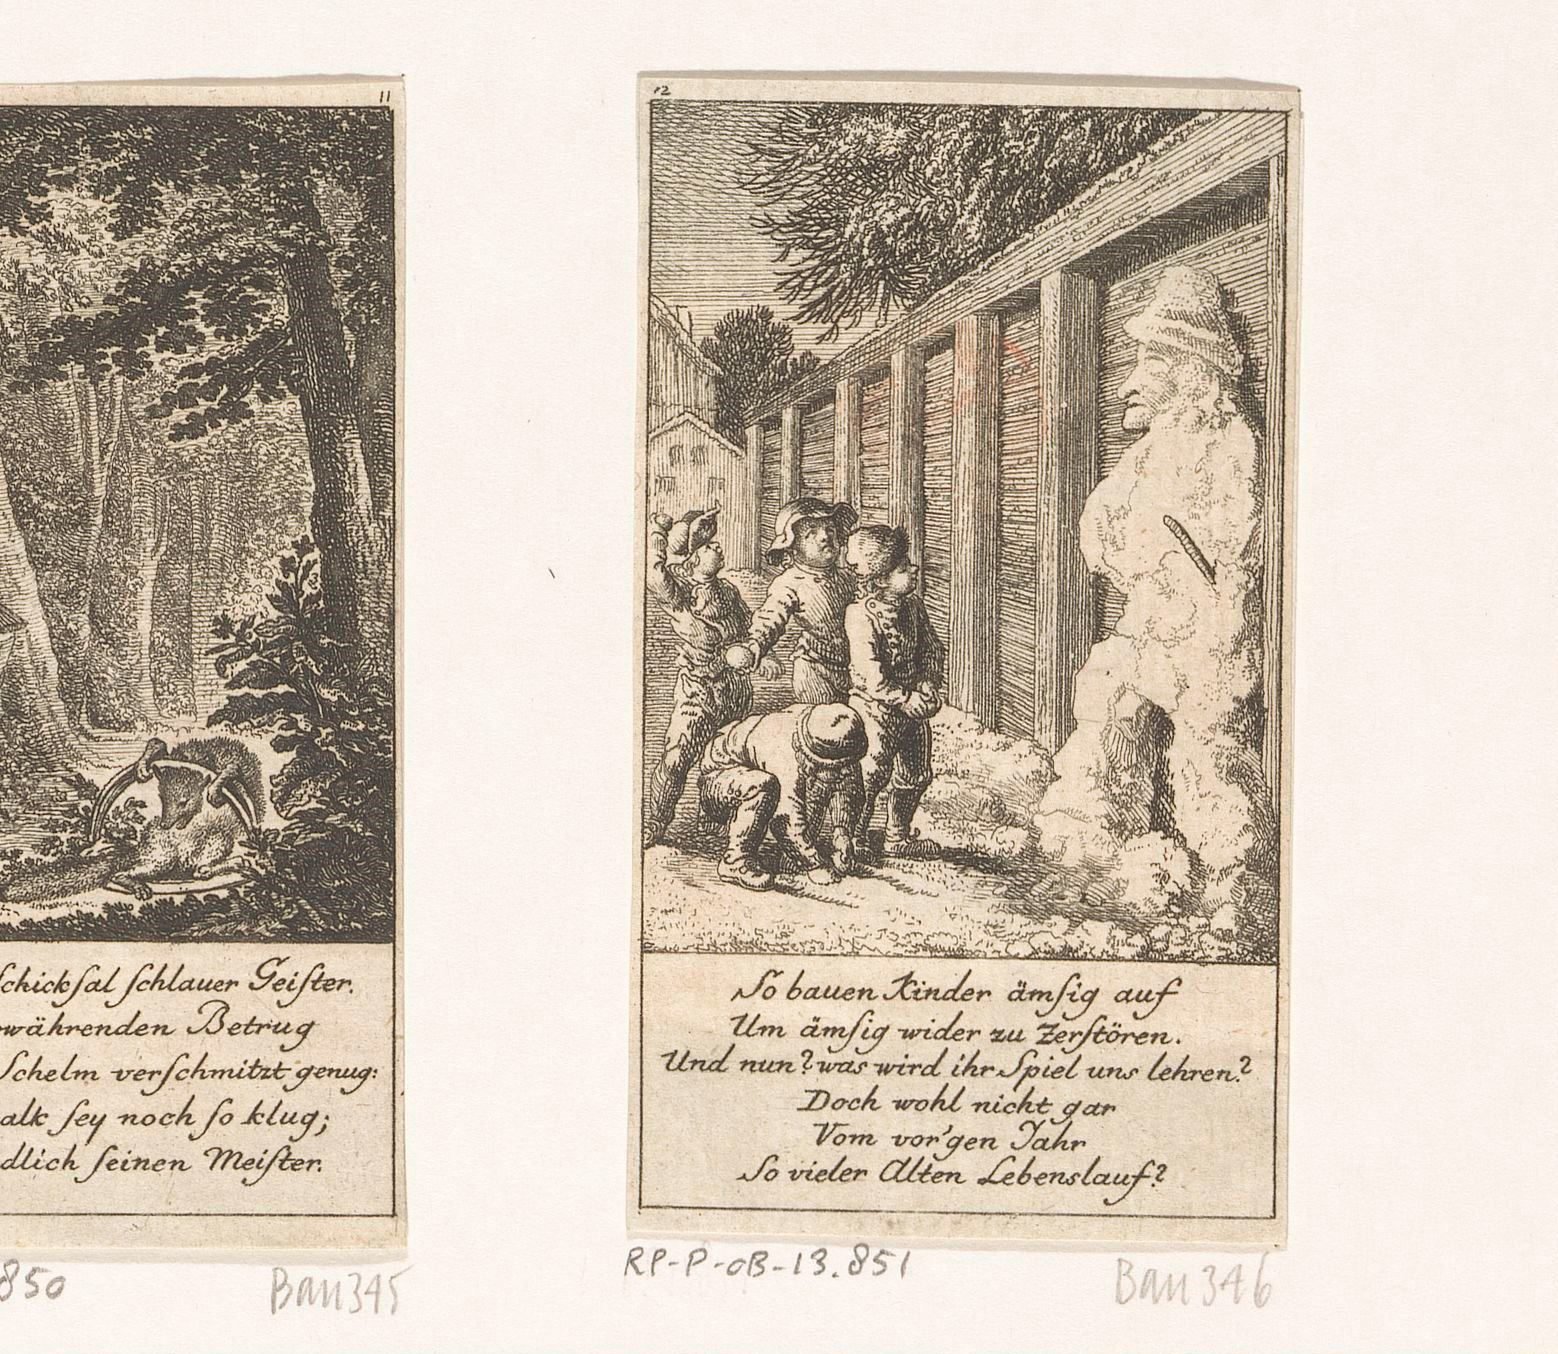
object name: print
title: December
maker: daniel nikolaus chodowiecki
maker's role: draughtsman, print maker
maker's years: 1726-1801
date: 1777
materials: paper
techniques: etching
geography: berlin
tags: (making a) snowman, december and its 'labours'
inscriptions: collector's mark: Lugt 2228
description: Afkomstig uit een serie met de twaalf maanden. Deze serie werd op een plaat geëtst. Deze serie is ook gebruikt in: Königl. Großbrit. Churf. Braunschw. Lüneb. Genealogischen Kalender, auf das Jahr 1778. Lauenburg: Johann Georg Berenberg.